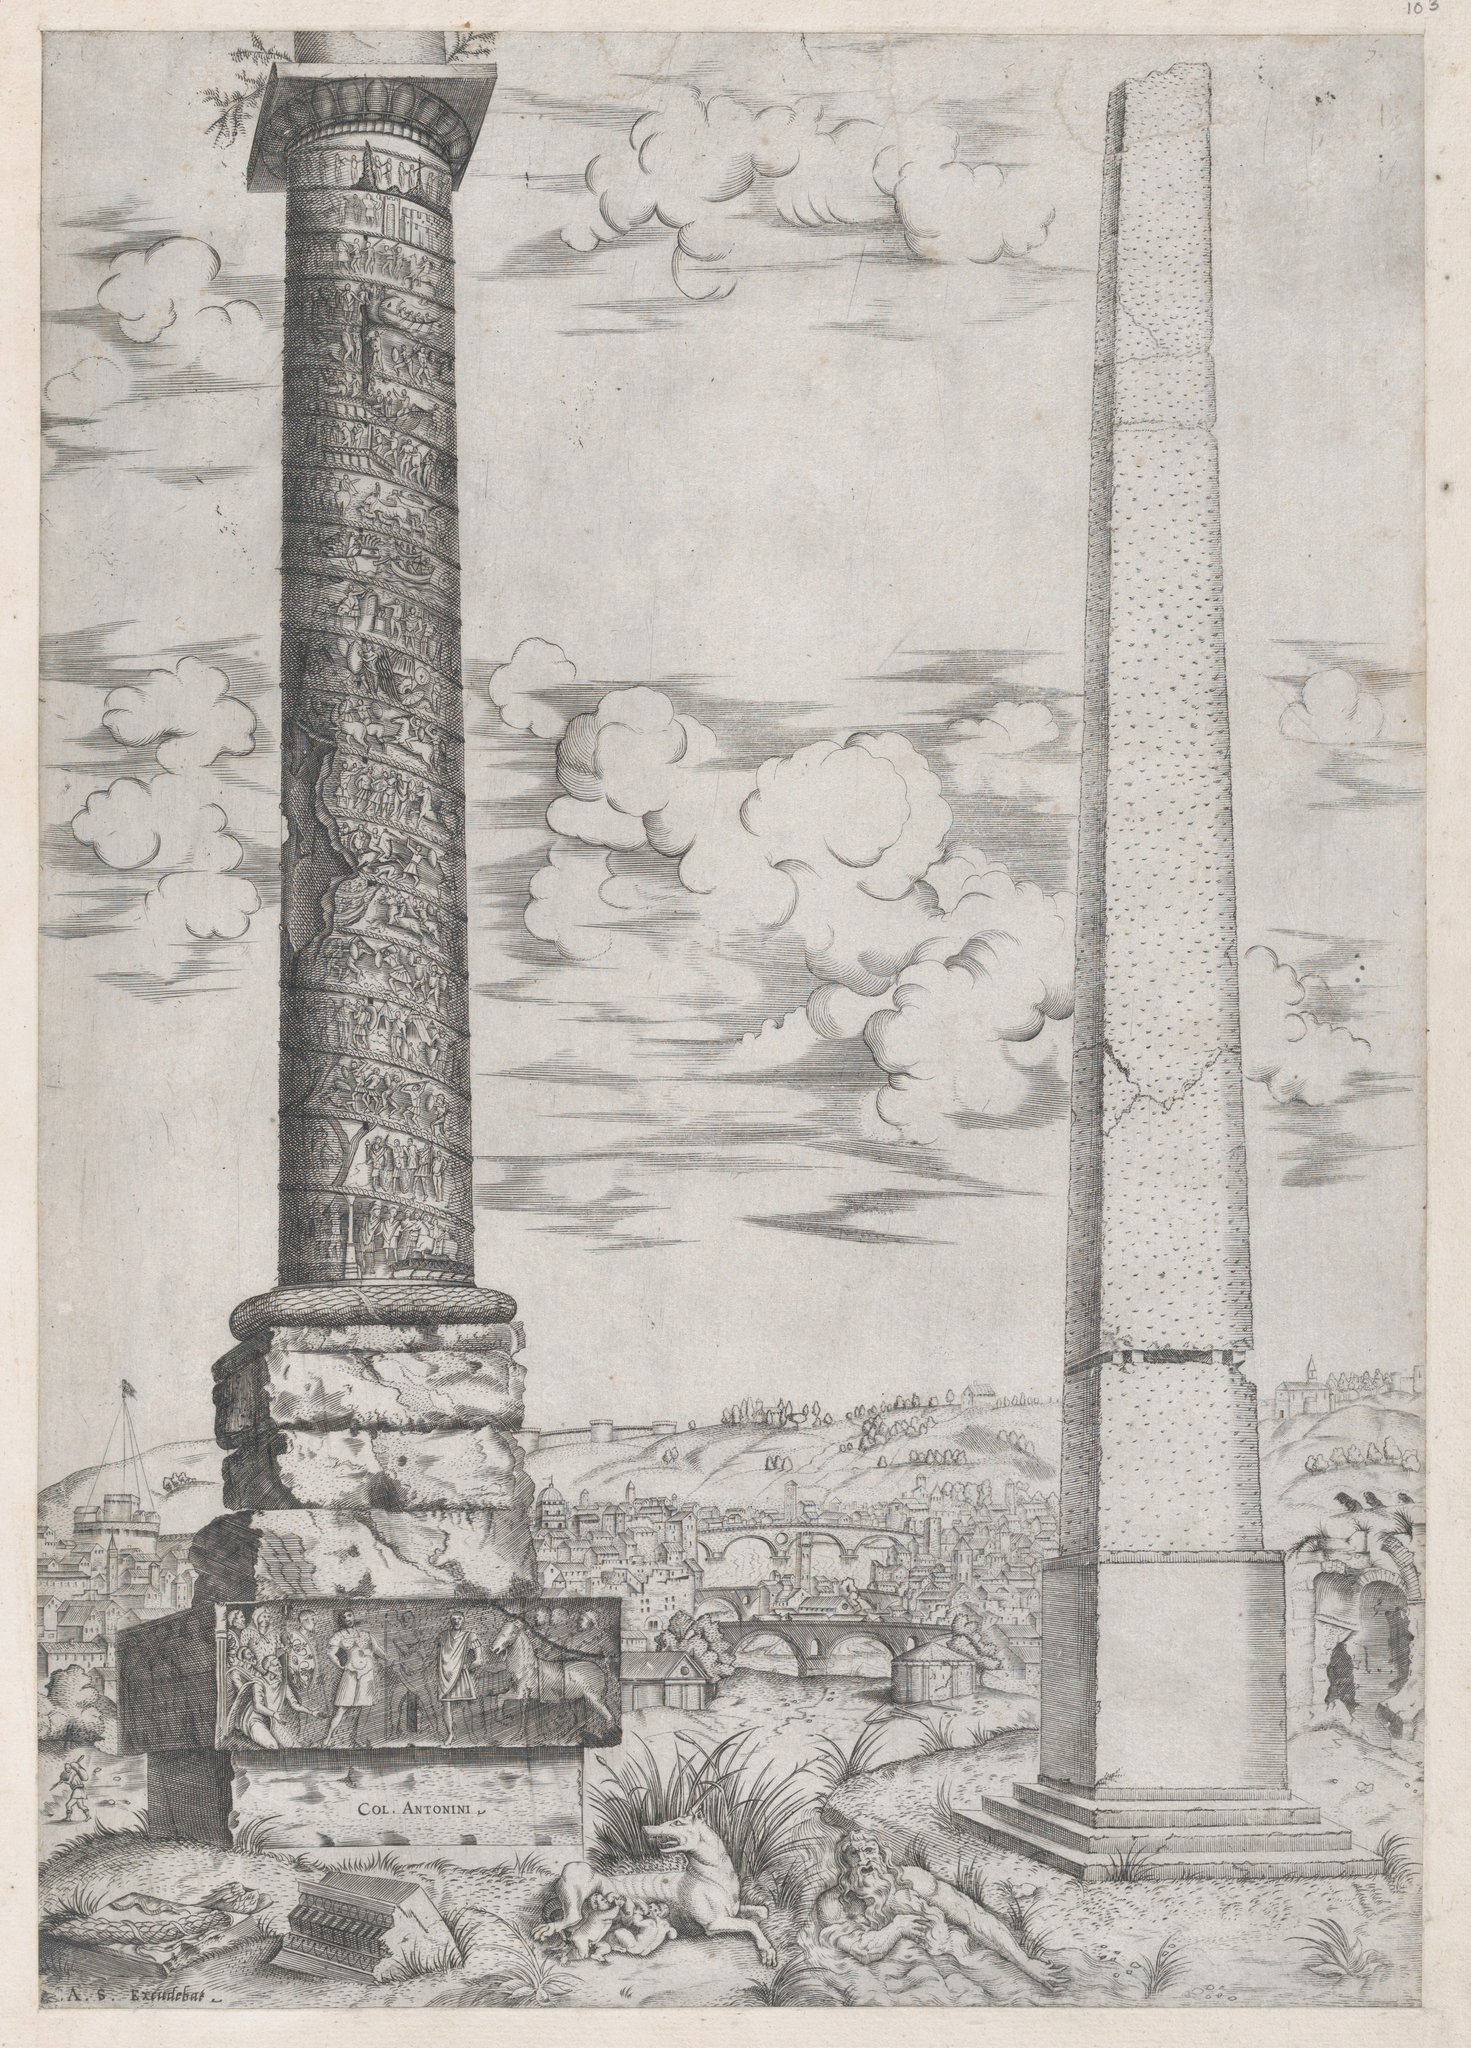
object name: print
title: Column of Antoninus and a Roman Obelisk, from "Speculum Romanae Magnificentiae"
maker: enea vico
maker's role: artist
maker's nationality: italian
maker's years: 1523-1567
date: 1543-1570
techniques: engraving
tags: columns,obelisks,rome